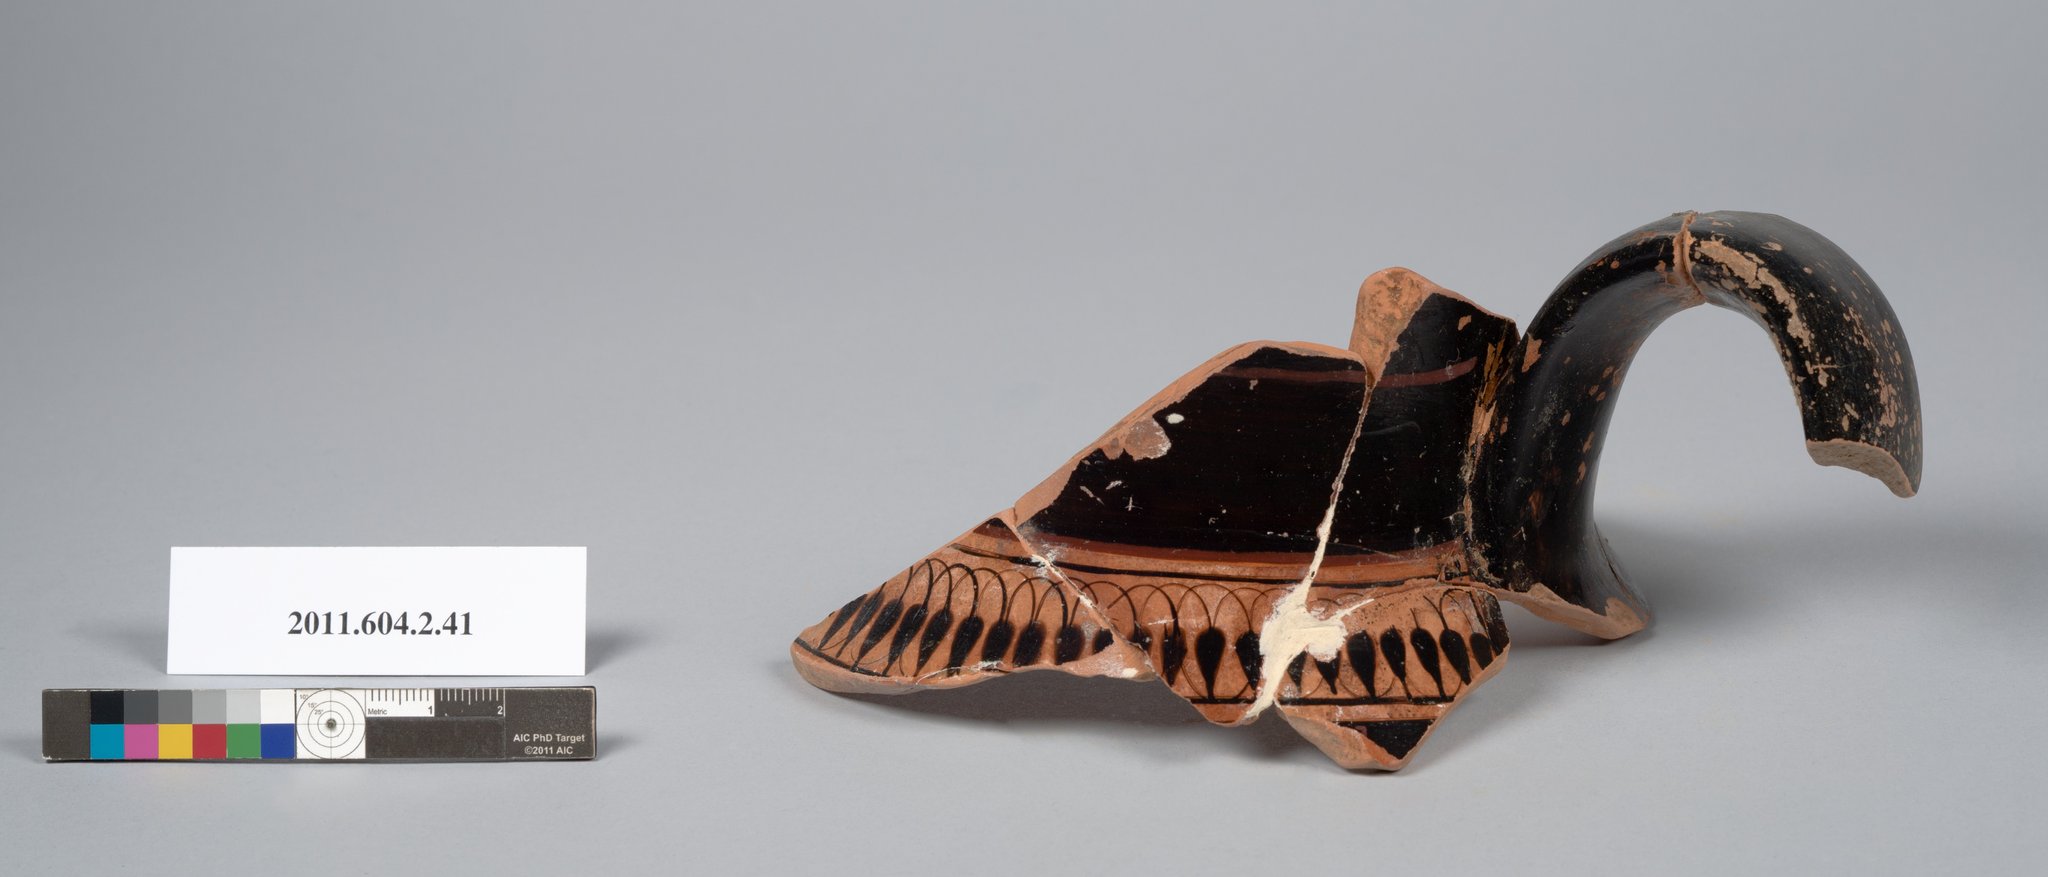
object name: pelike fragment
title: Terracotta fragment of a pelike (jar)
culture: greek, attic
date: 534-468 BCE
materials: terracotta